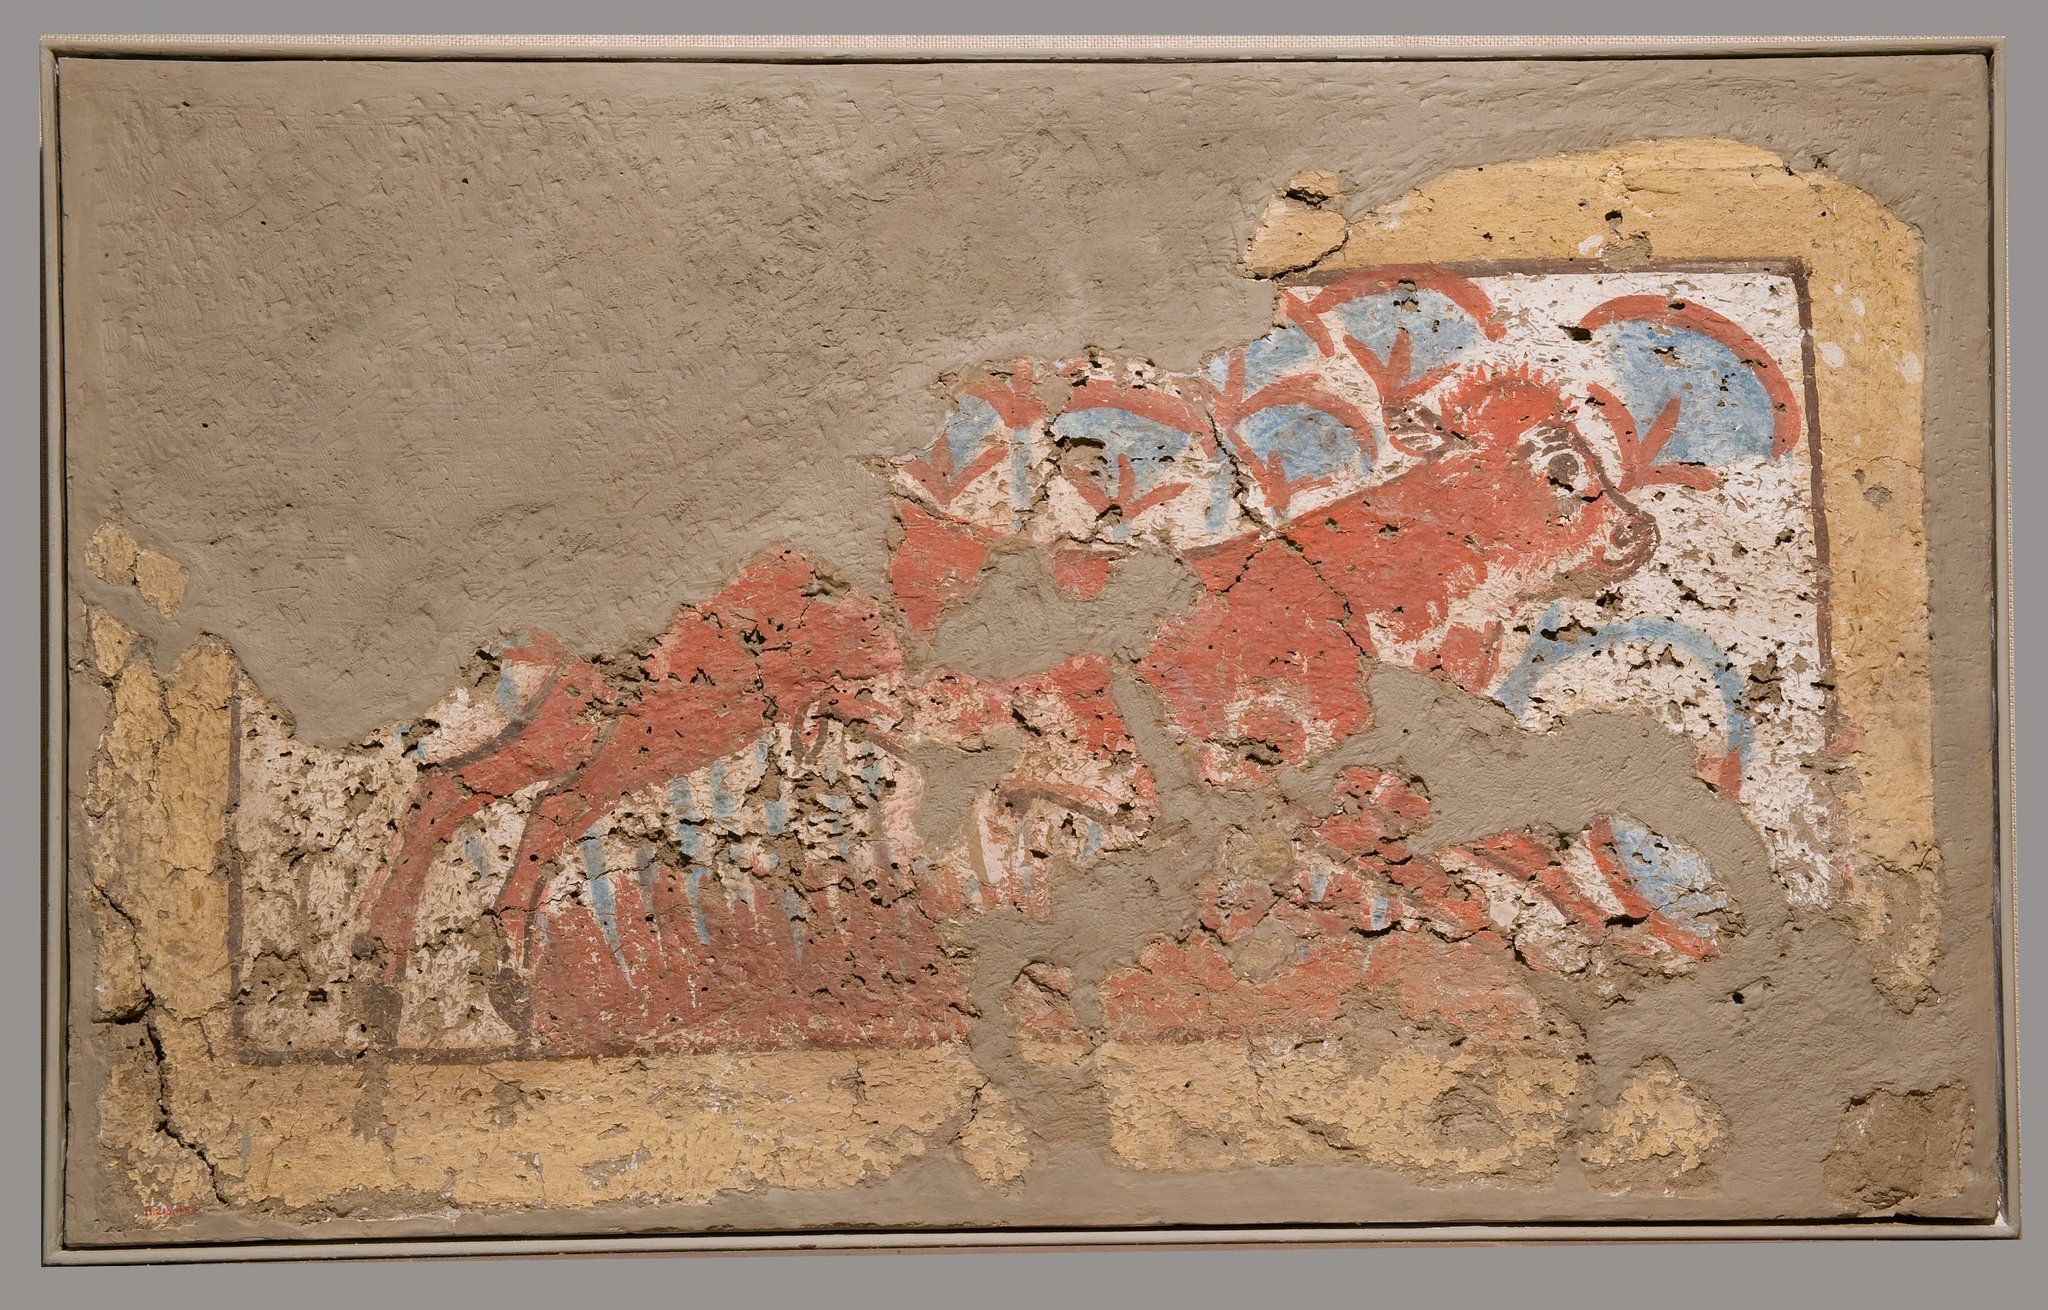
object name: painting, calf in the marsh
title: Bench Side-Panel Depicting a Calf in the Marshes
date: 1390-1352 BCE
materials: mud, paint, plaster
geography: egypt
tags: animals